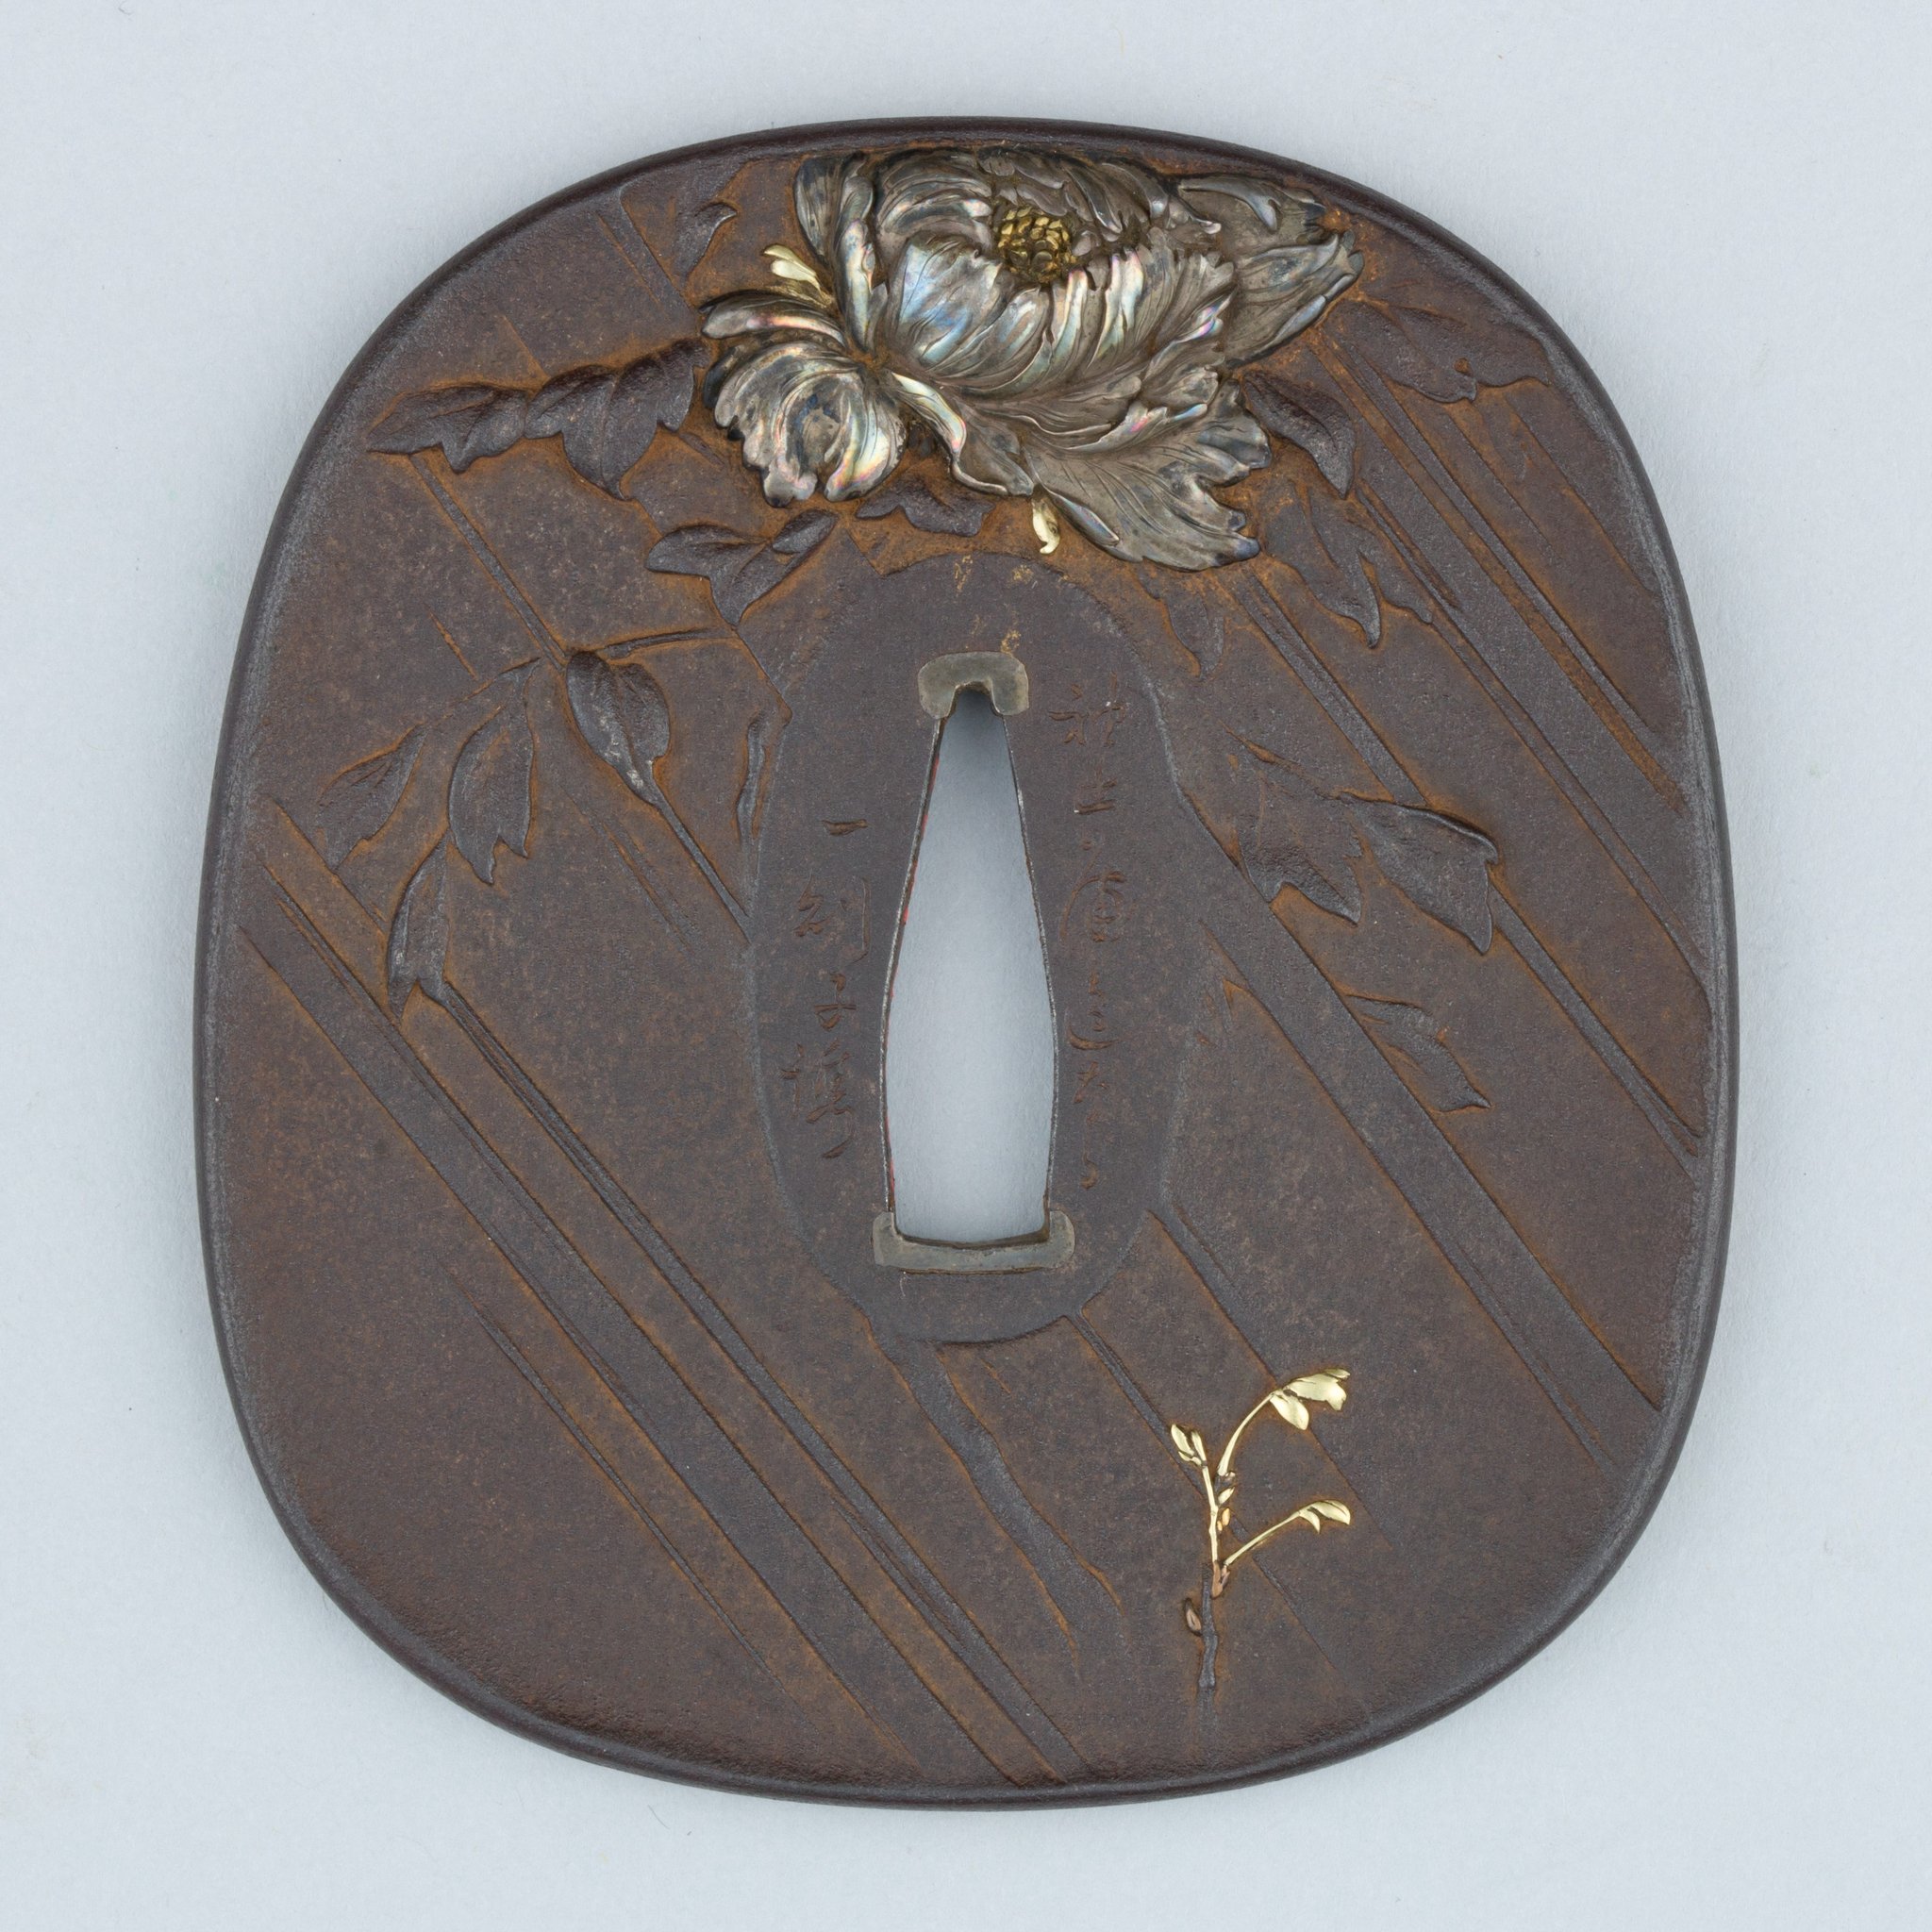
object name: sword guard tsuba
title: Sword Guard (Tsuba)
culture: japanese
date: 1615-1868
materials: copper, copper alloy, gold, iron, silver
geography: japan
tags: flowers